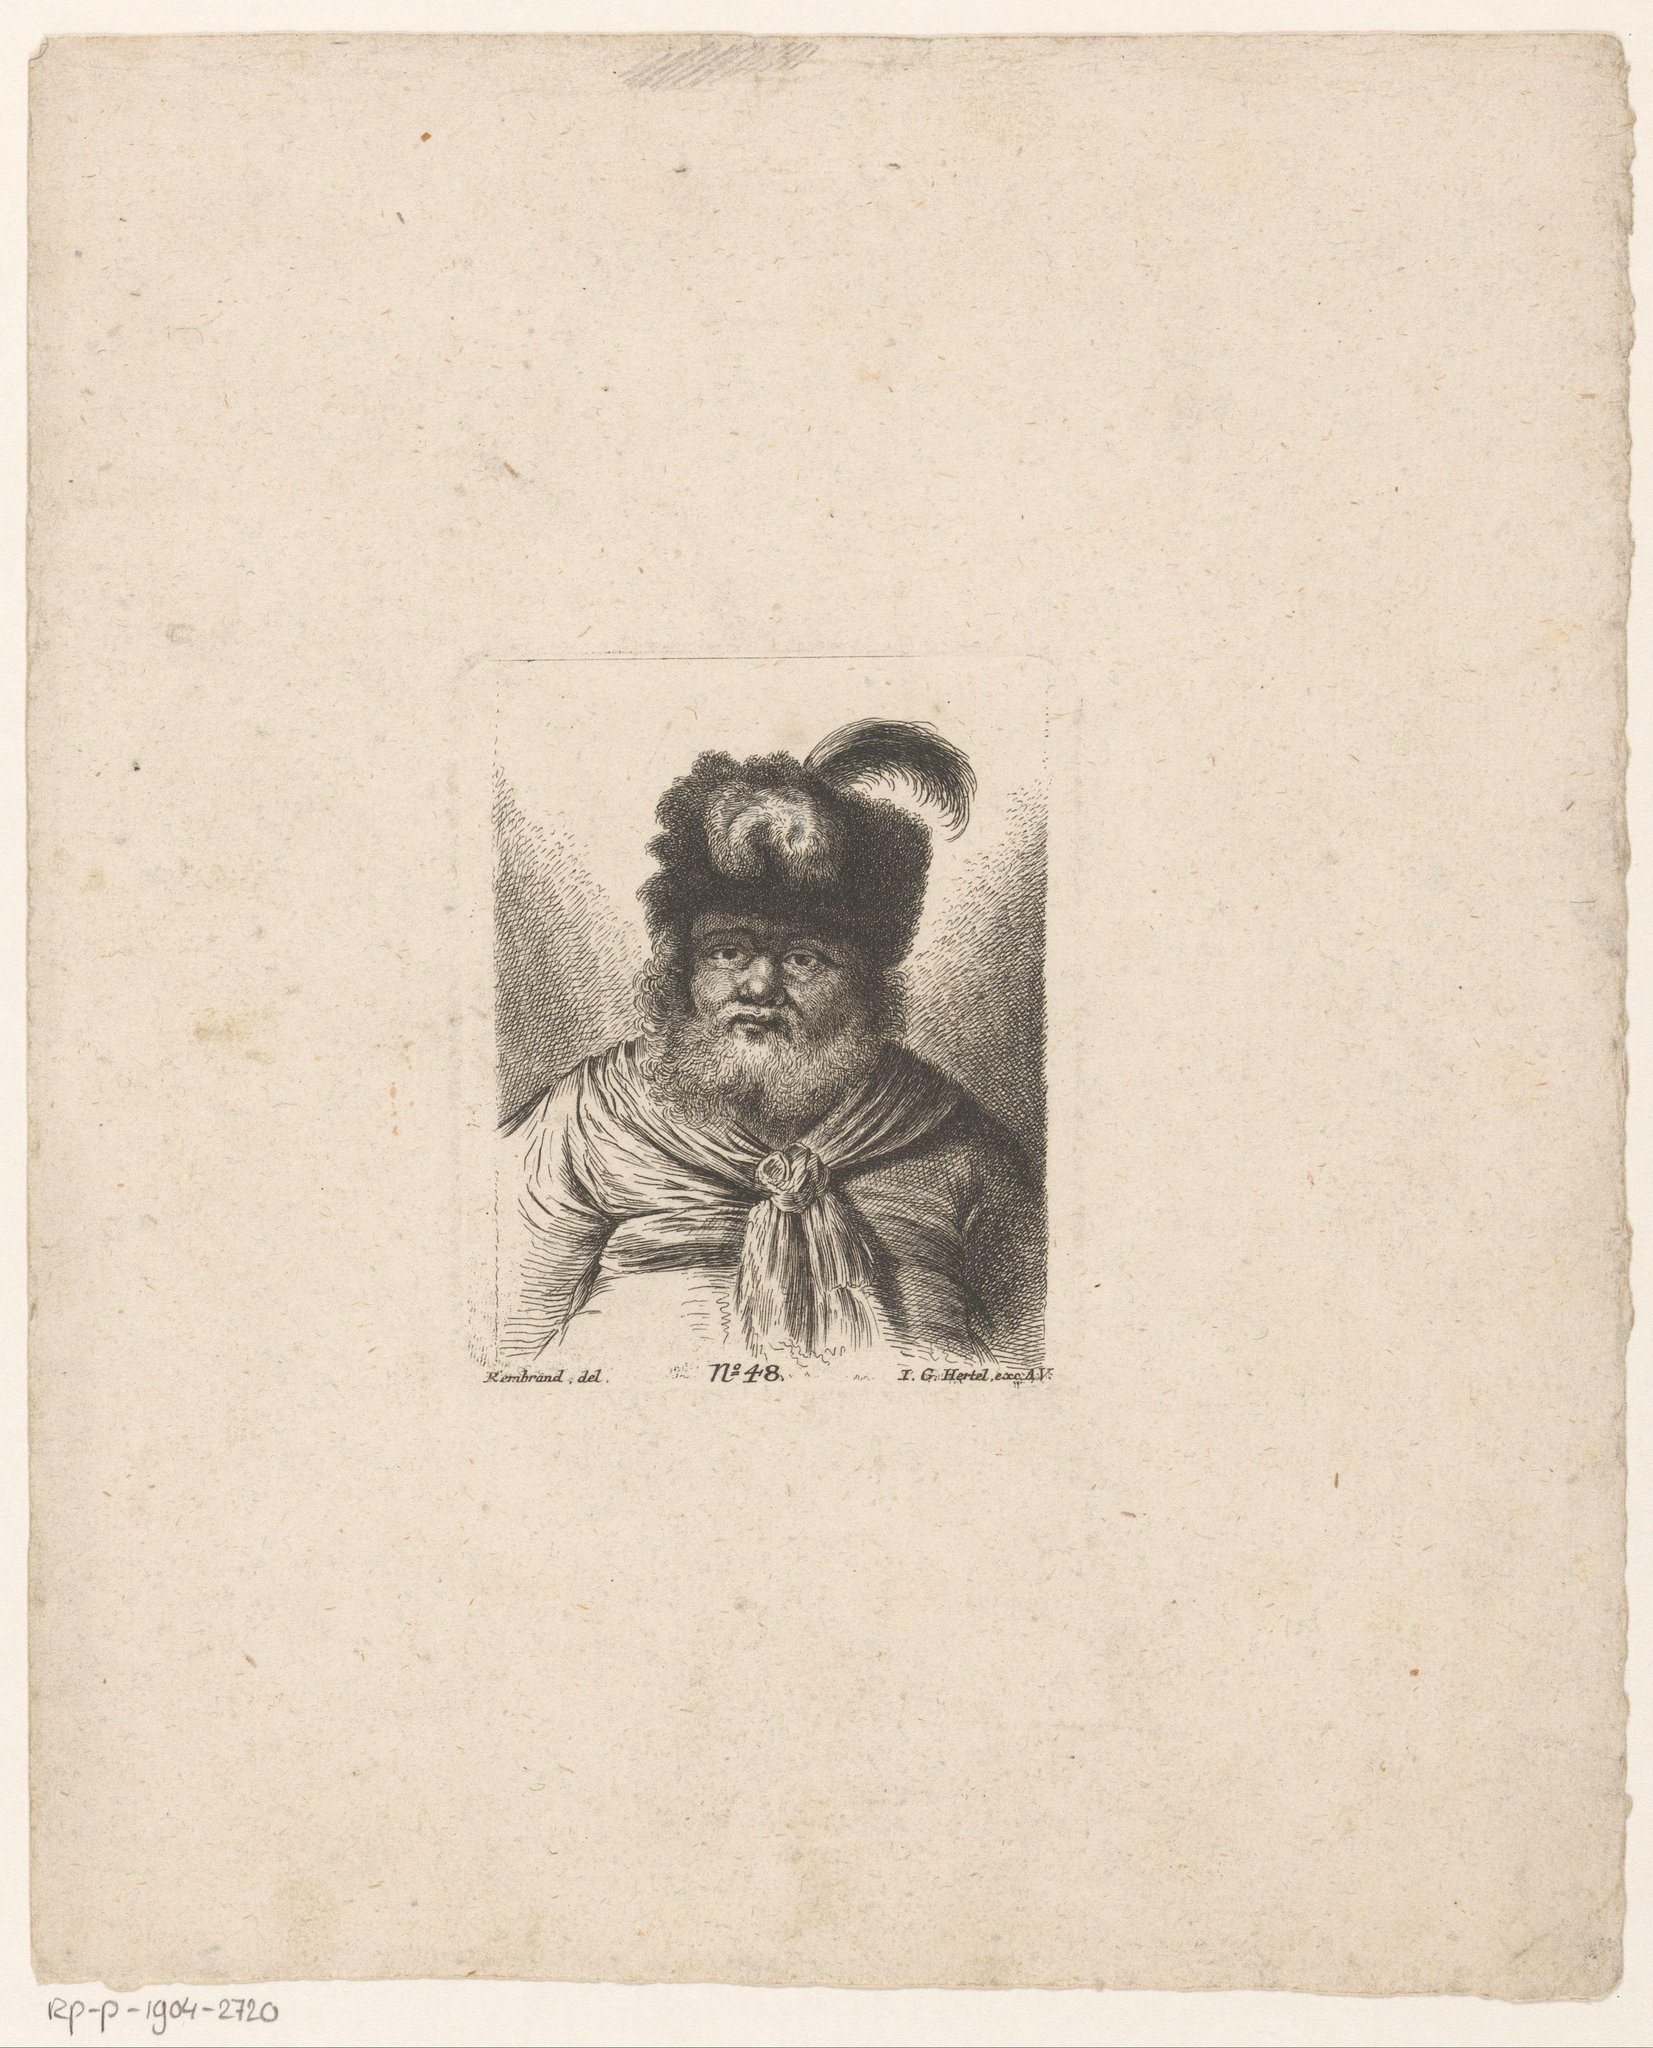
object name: print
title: Oude man met baard en bontmuts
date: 1705-1775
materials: paper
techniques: etching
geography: augsburg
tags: old man, head-gear: cap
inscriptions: collector's mark: Lugt 2228